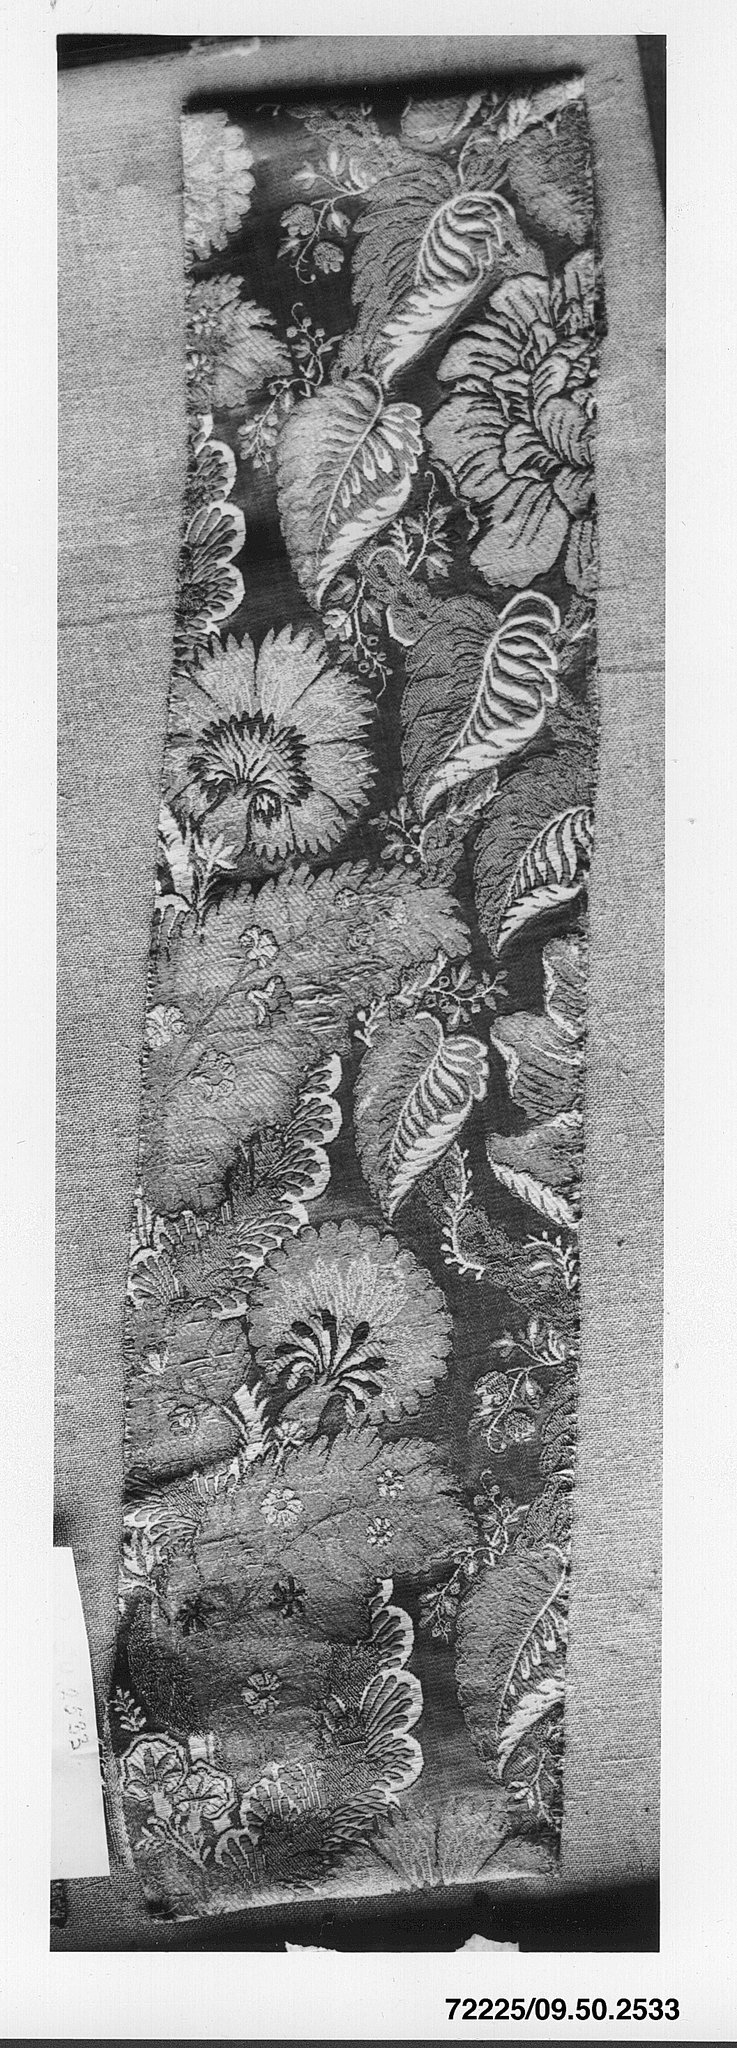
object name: piece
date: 1730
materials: metal thread, silk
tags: flowers,leaves